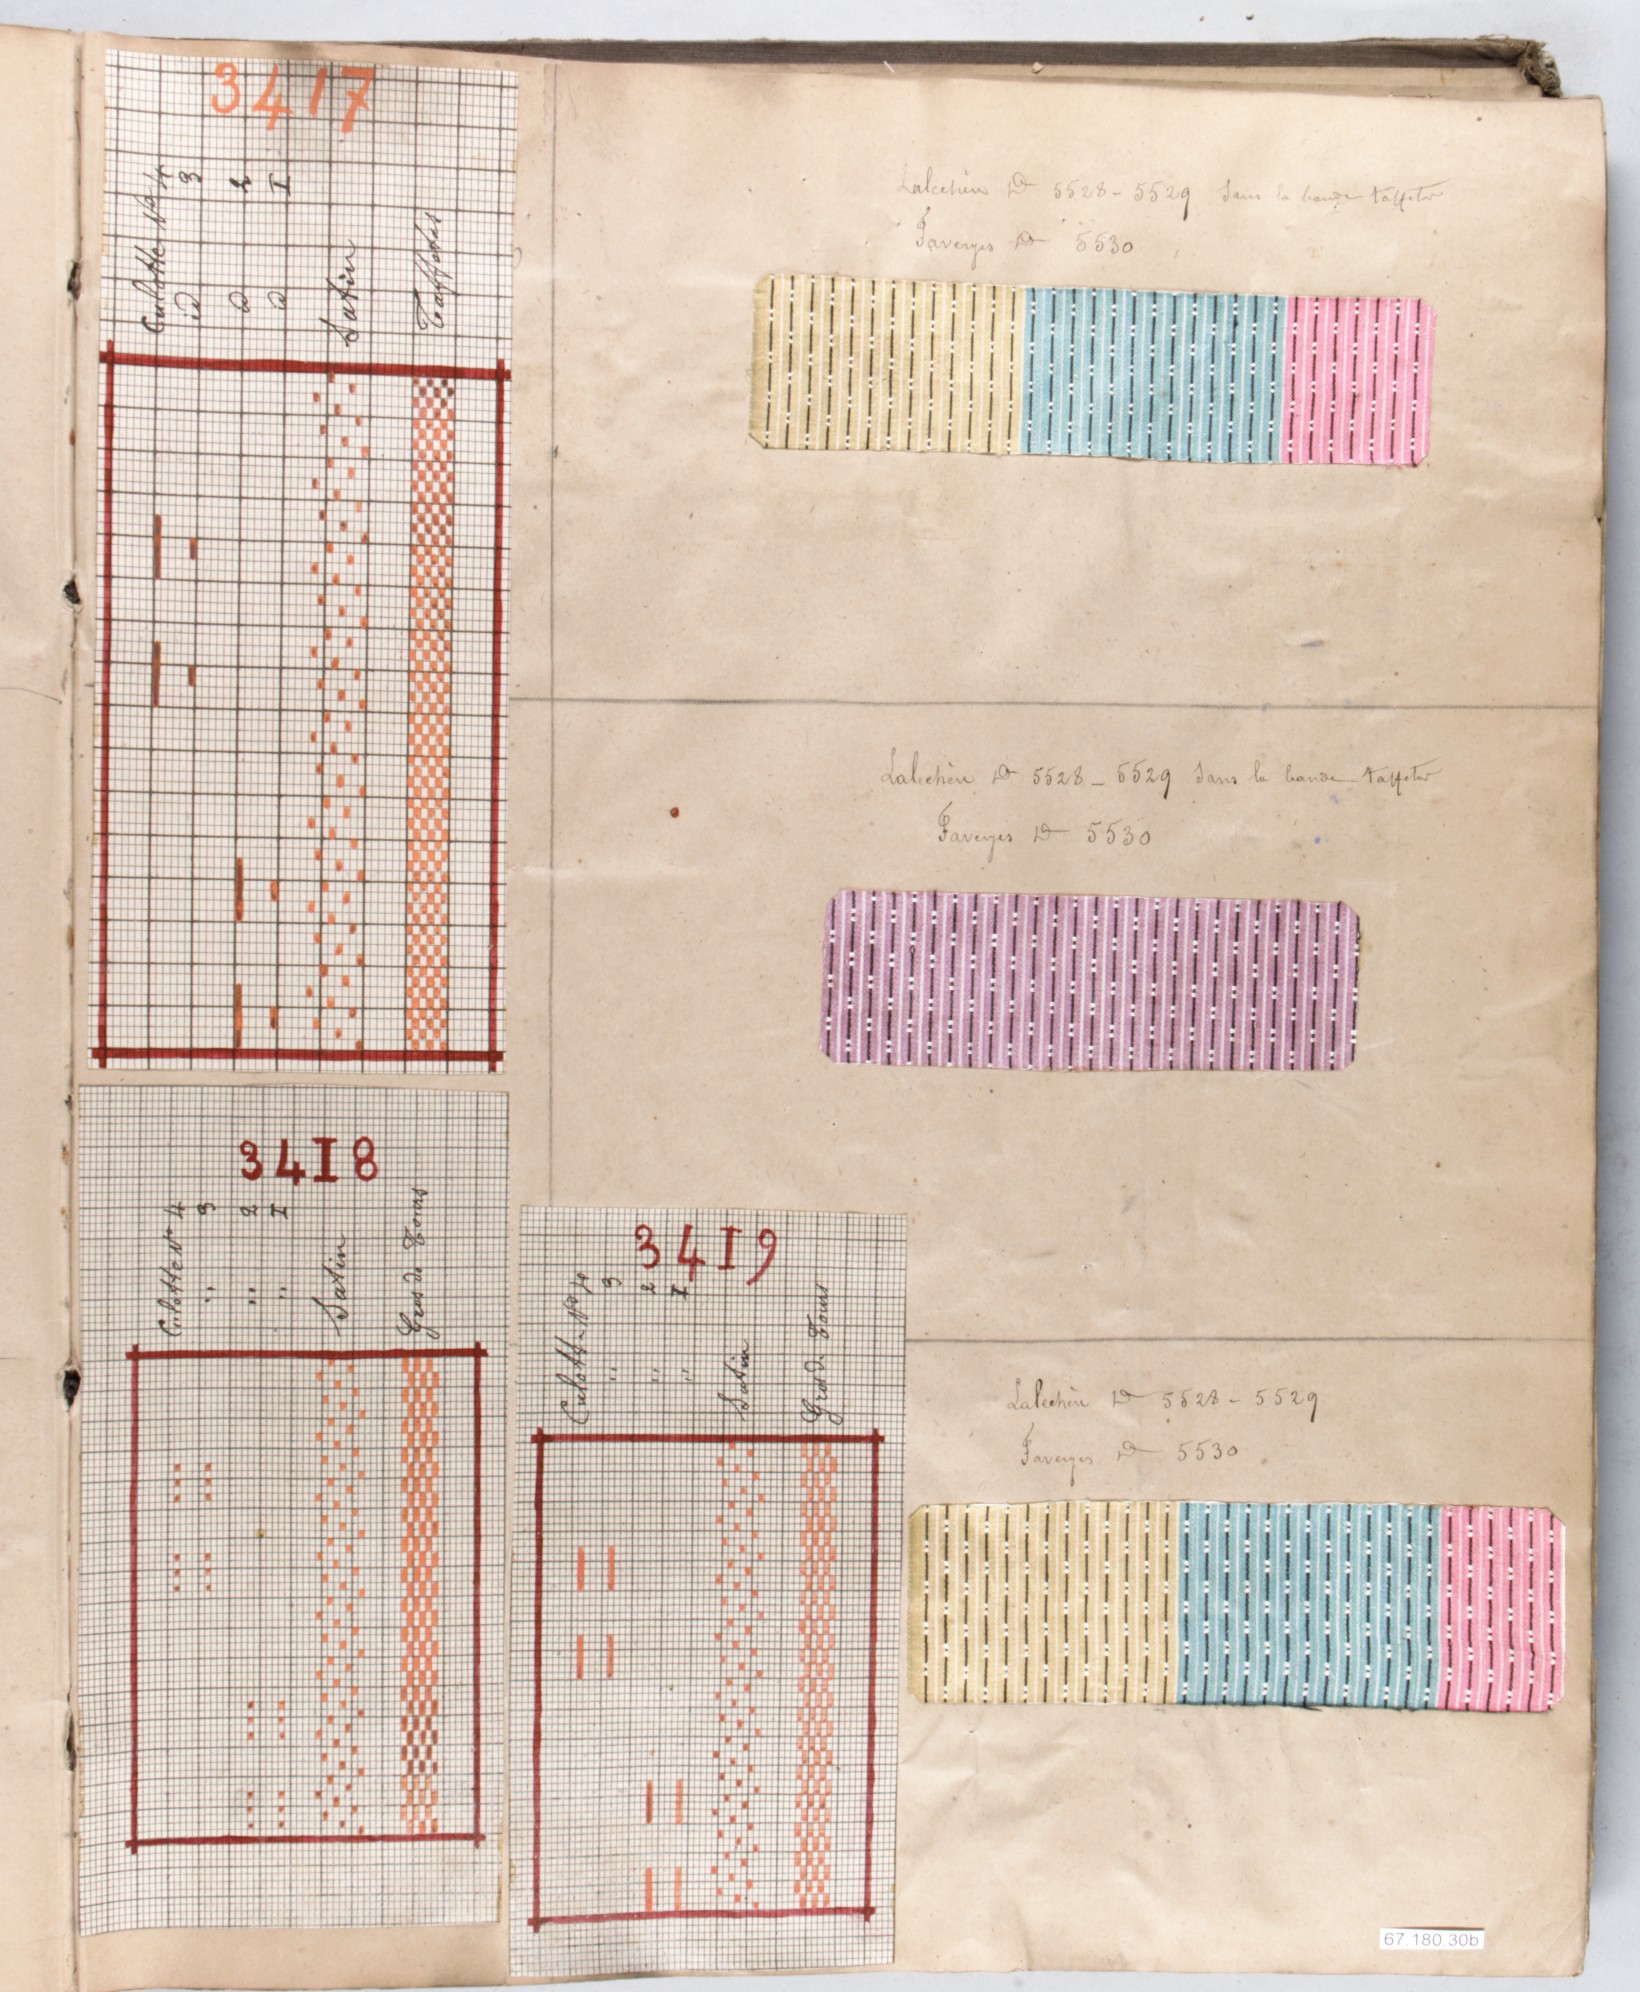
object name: work book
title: Work book, swatches, and drafts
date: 1867-1900